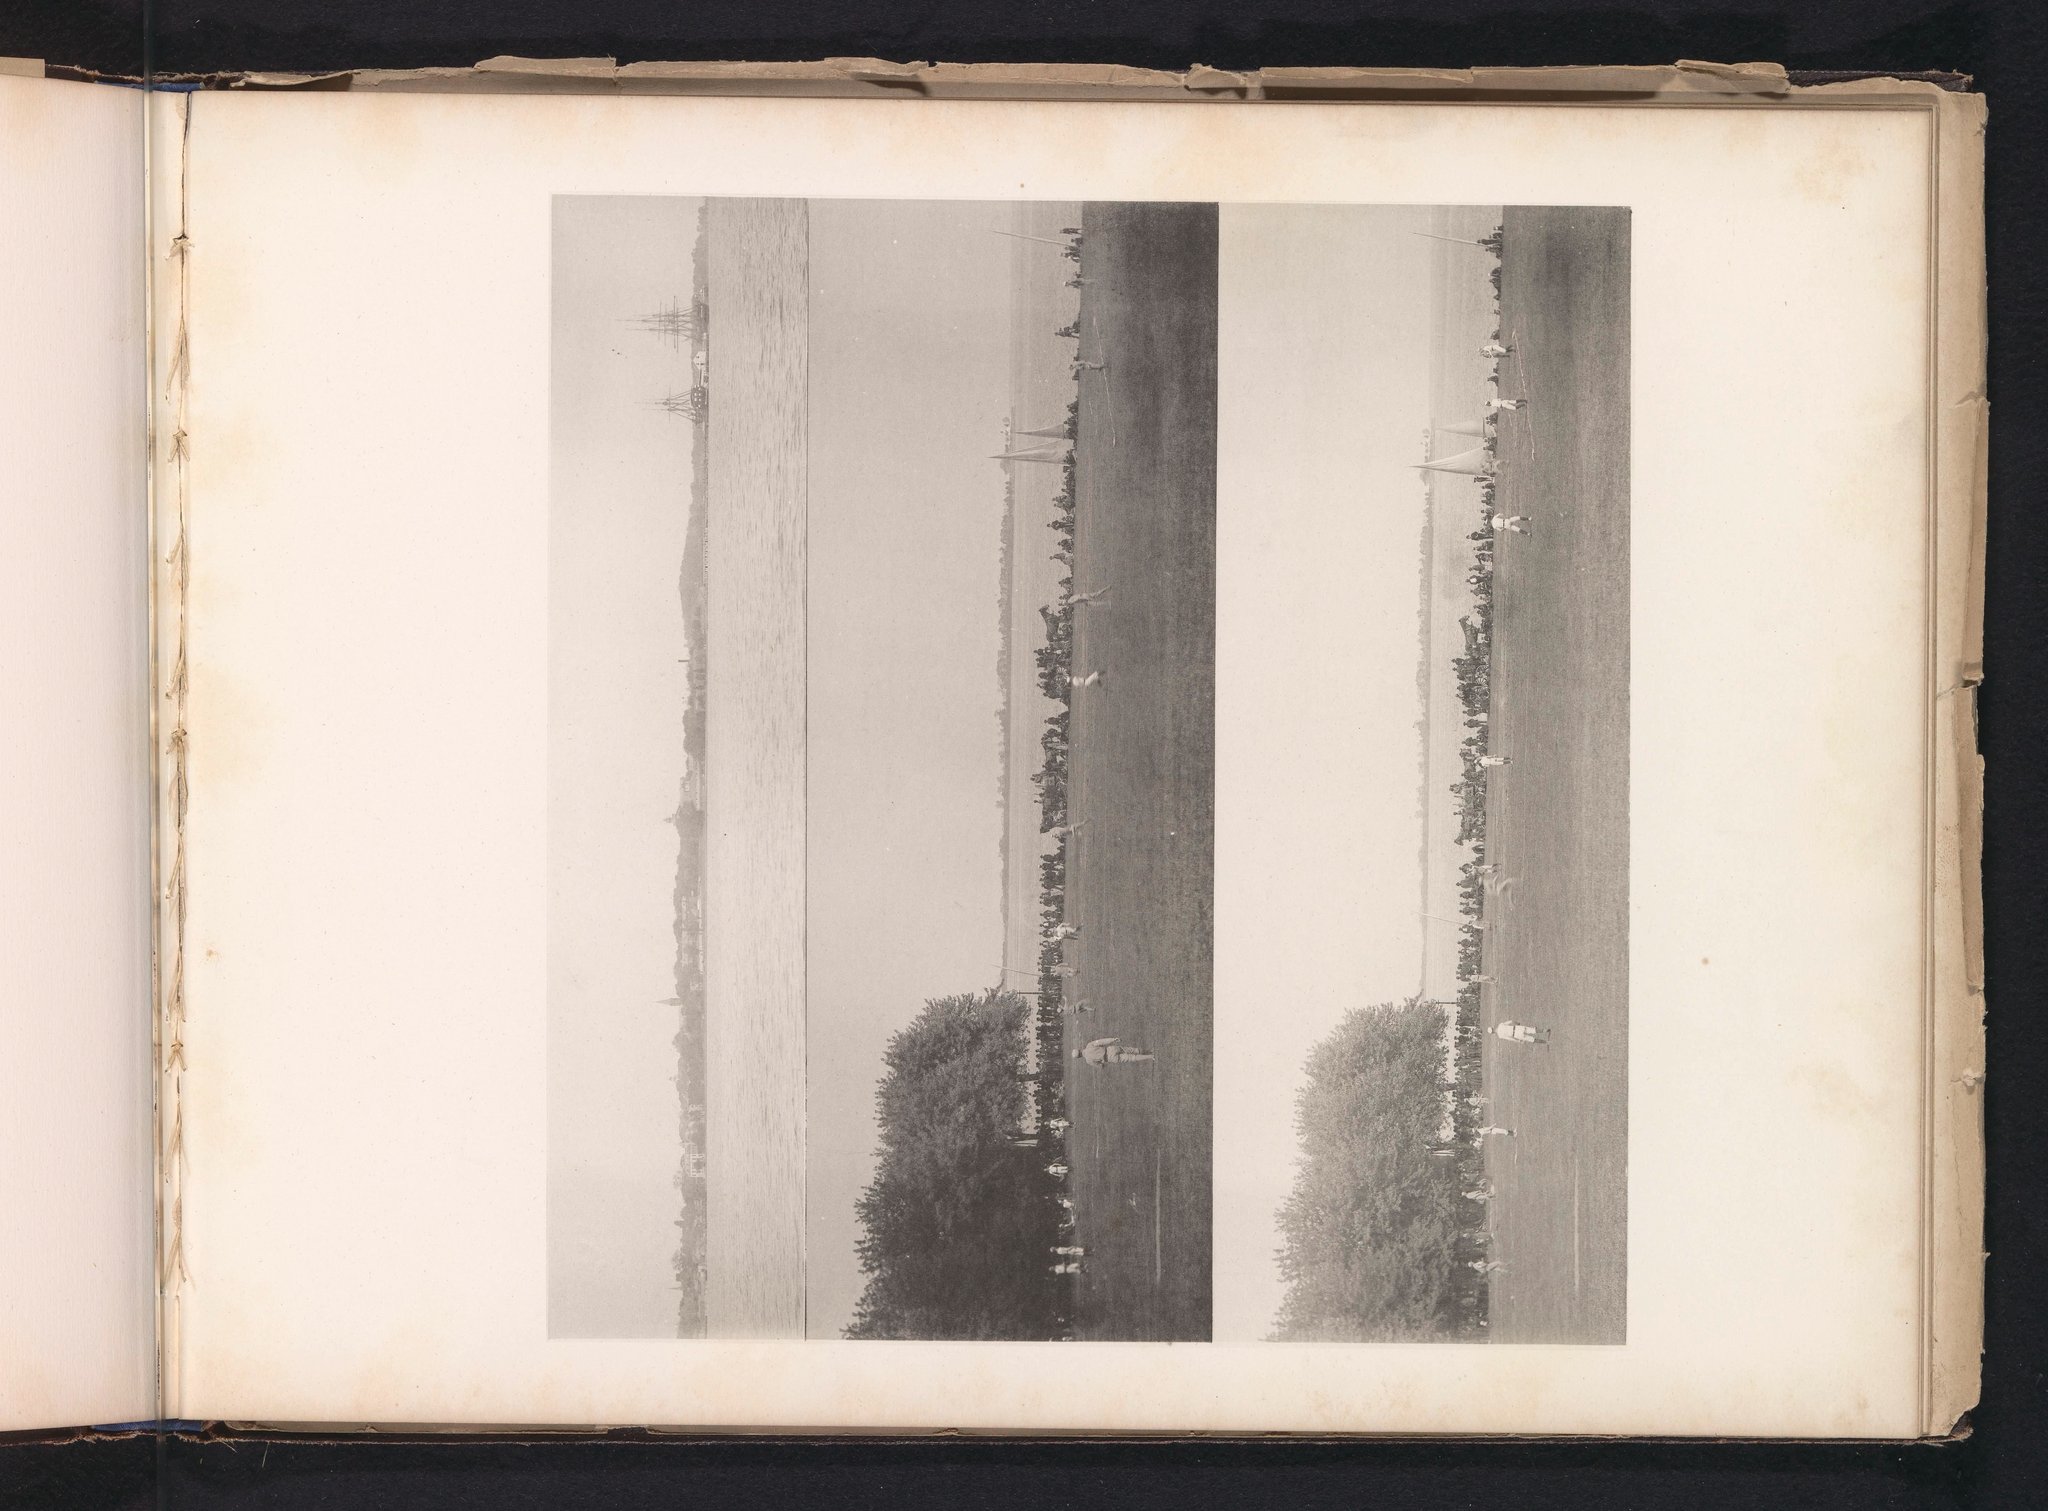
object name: page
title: Gezicht op Annapolis en twee gezichten op een honkbalwedstrijd (vermoedelijk) van kadetten van de United States Naval Academy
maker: edward h. hart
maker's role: publisher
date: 1885-1890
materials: paper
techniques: photograph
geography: new york city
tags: city-view in general; 'veduta', baseball